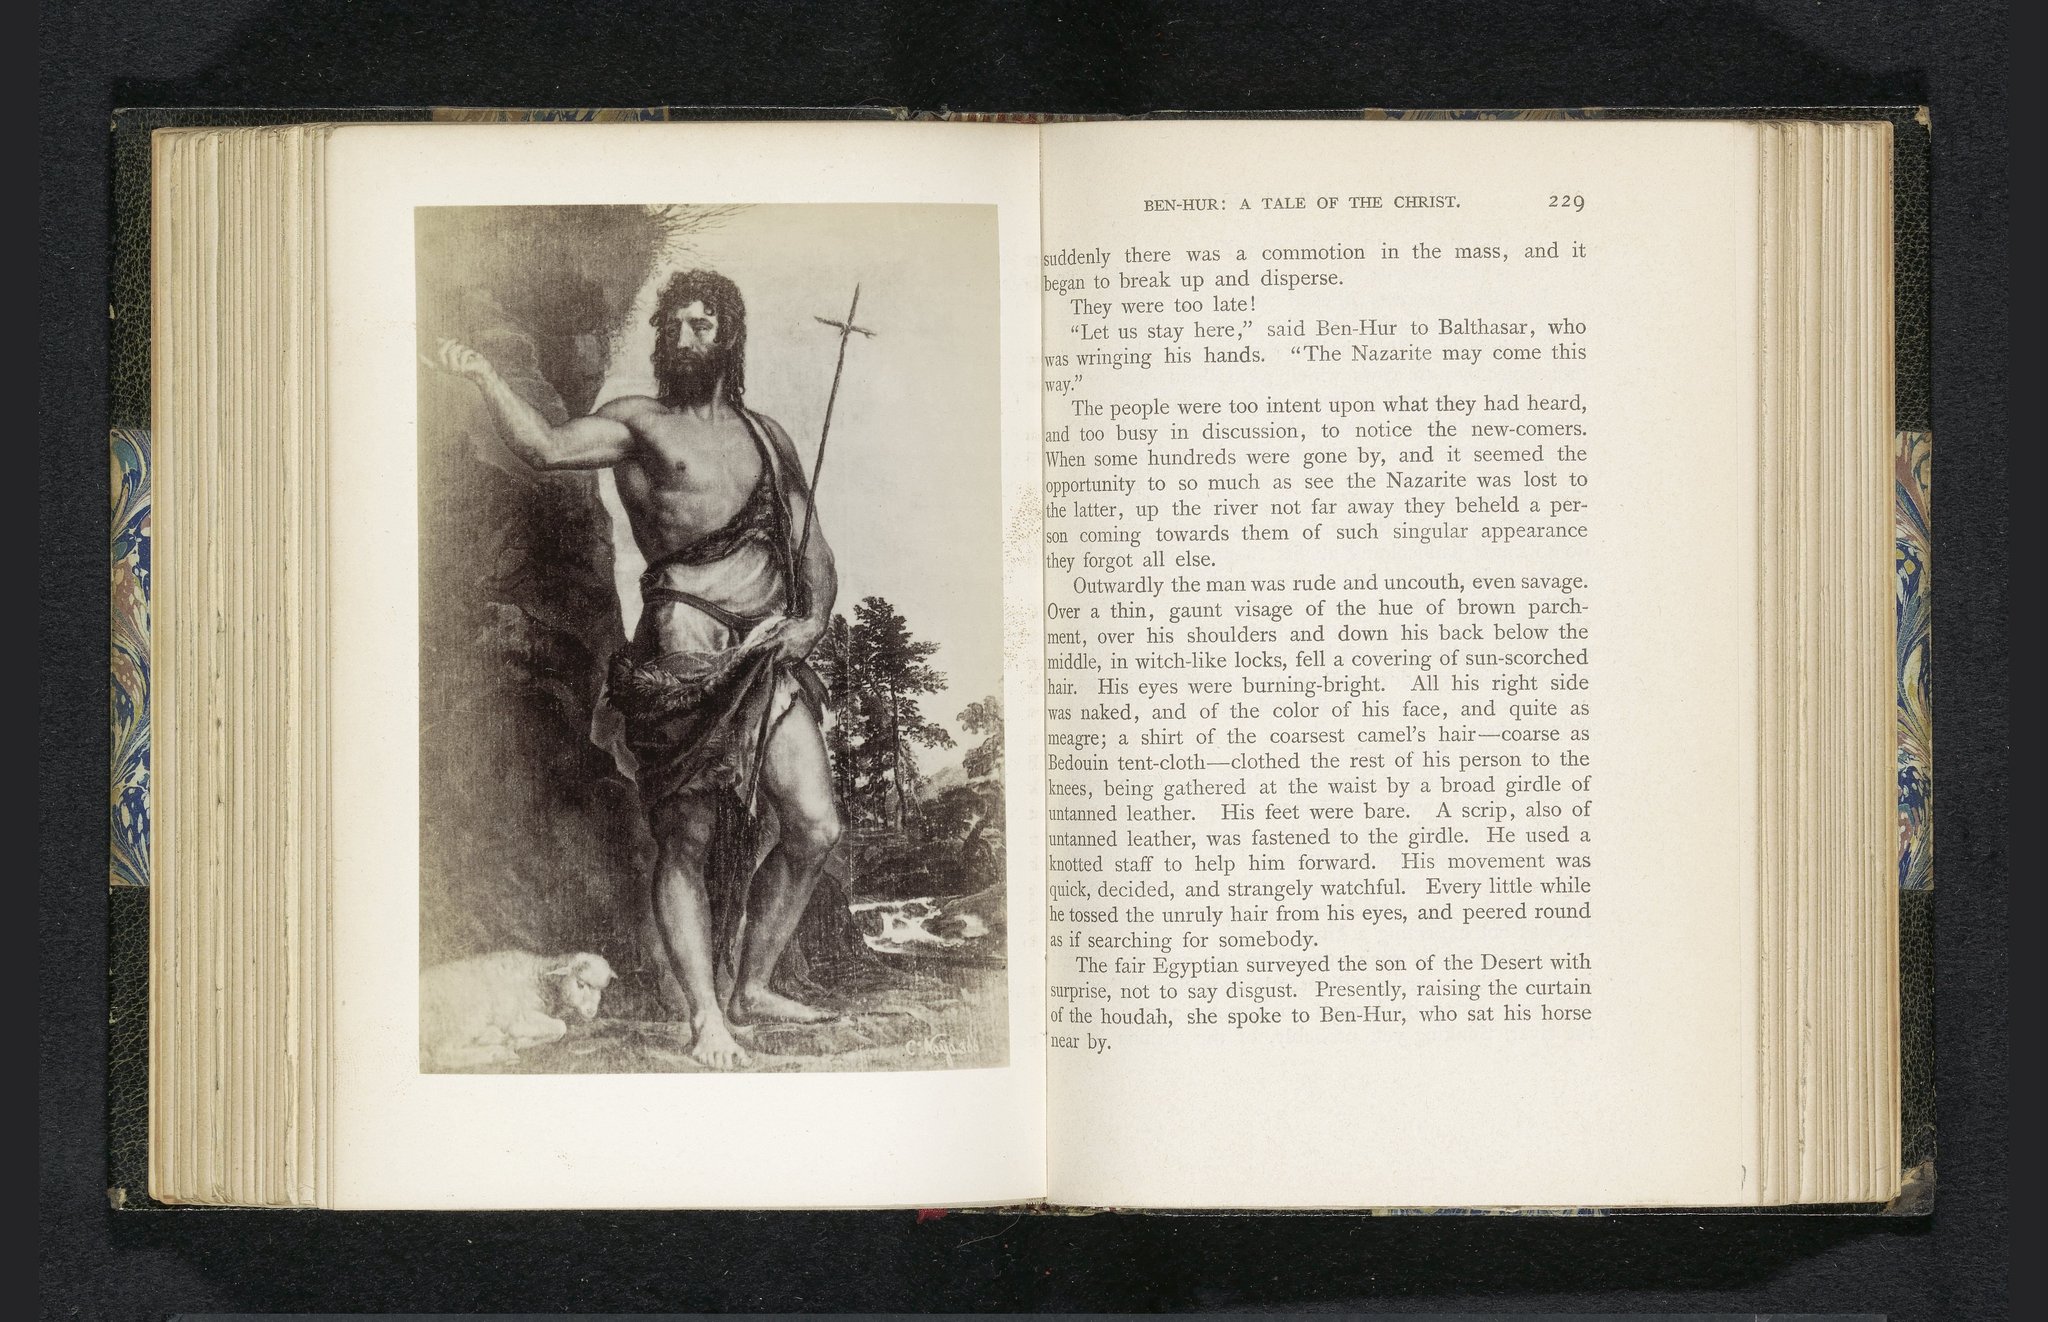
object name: reproduction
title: Fotoreproductie van een schilderij, voorstellende Johannes de Doper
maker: carlo naya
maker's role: fotograaf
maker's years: 1816-1882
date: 1883-1888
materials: photographic support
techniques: albumen print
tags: john the baptist; possible attributes: book, reed cross, baptismal cup, honeycomb, lamb, staff, lamb